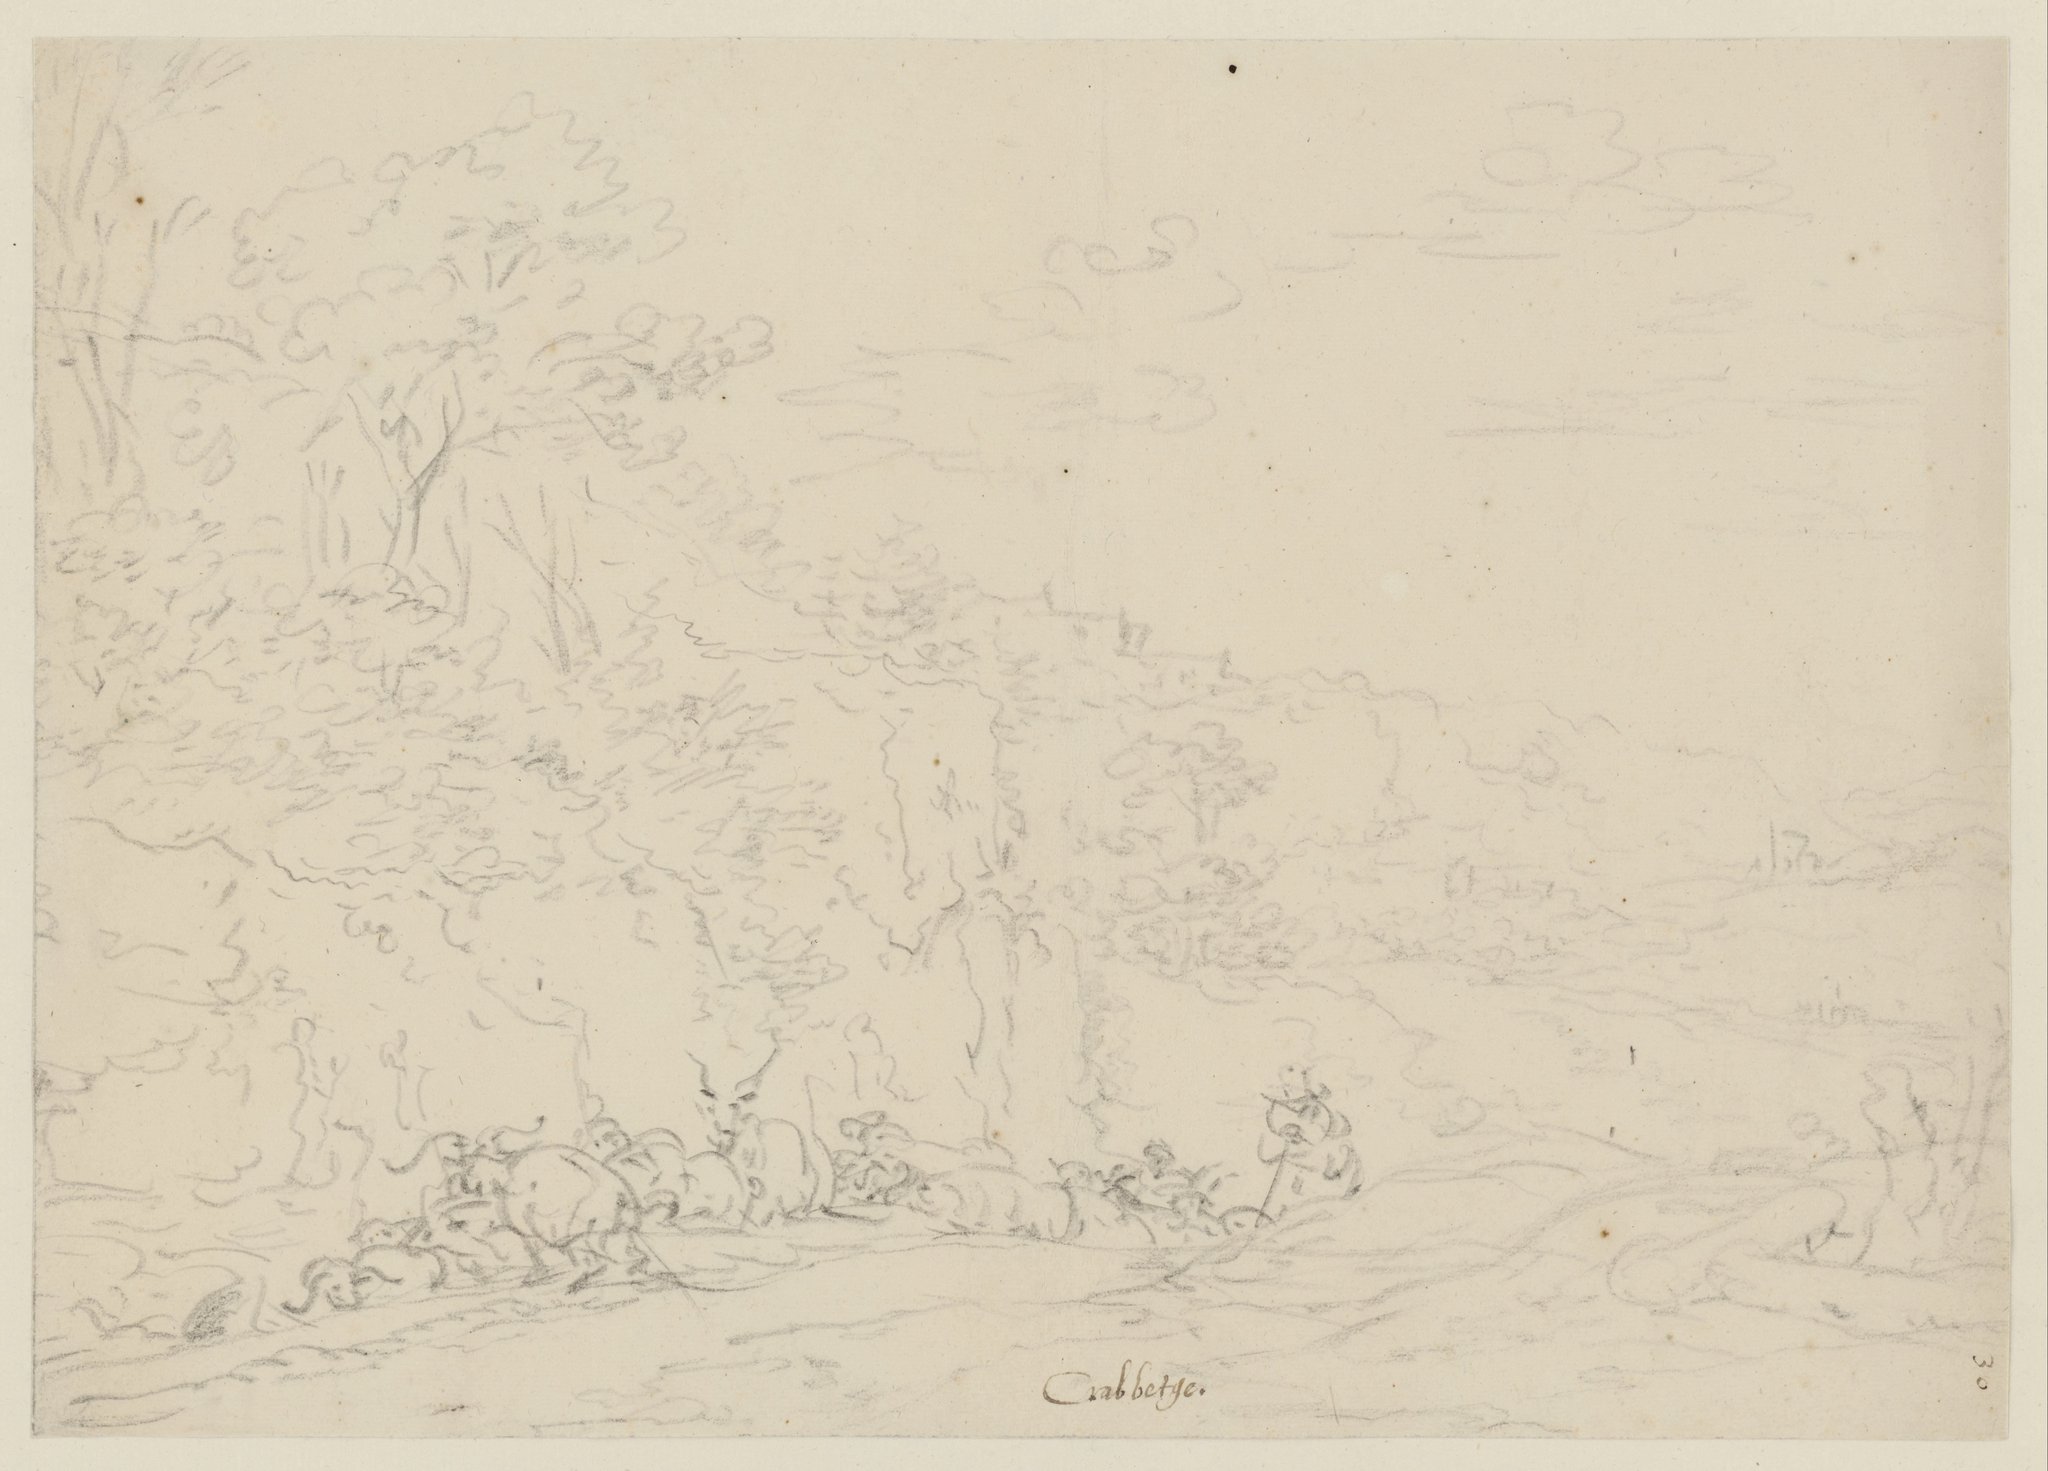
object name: album leaf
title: Heuvellandschap met vee en herder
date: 1642-1653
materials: chalk, paper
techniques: pasting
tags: low hill country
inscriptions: number: ‘30’, inscription: ‘Crabbetje.’